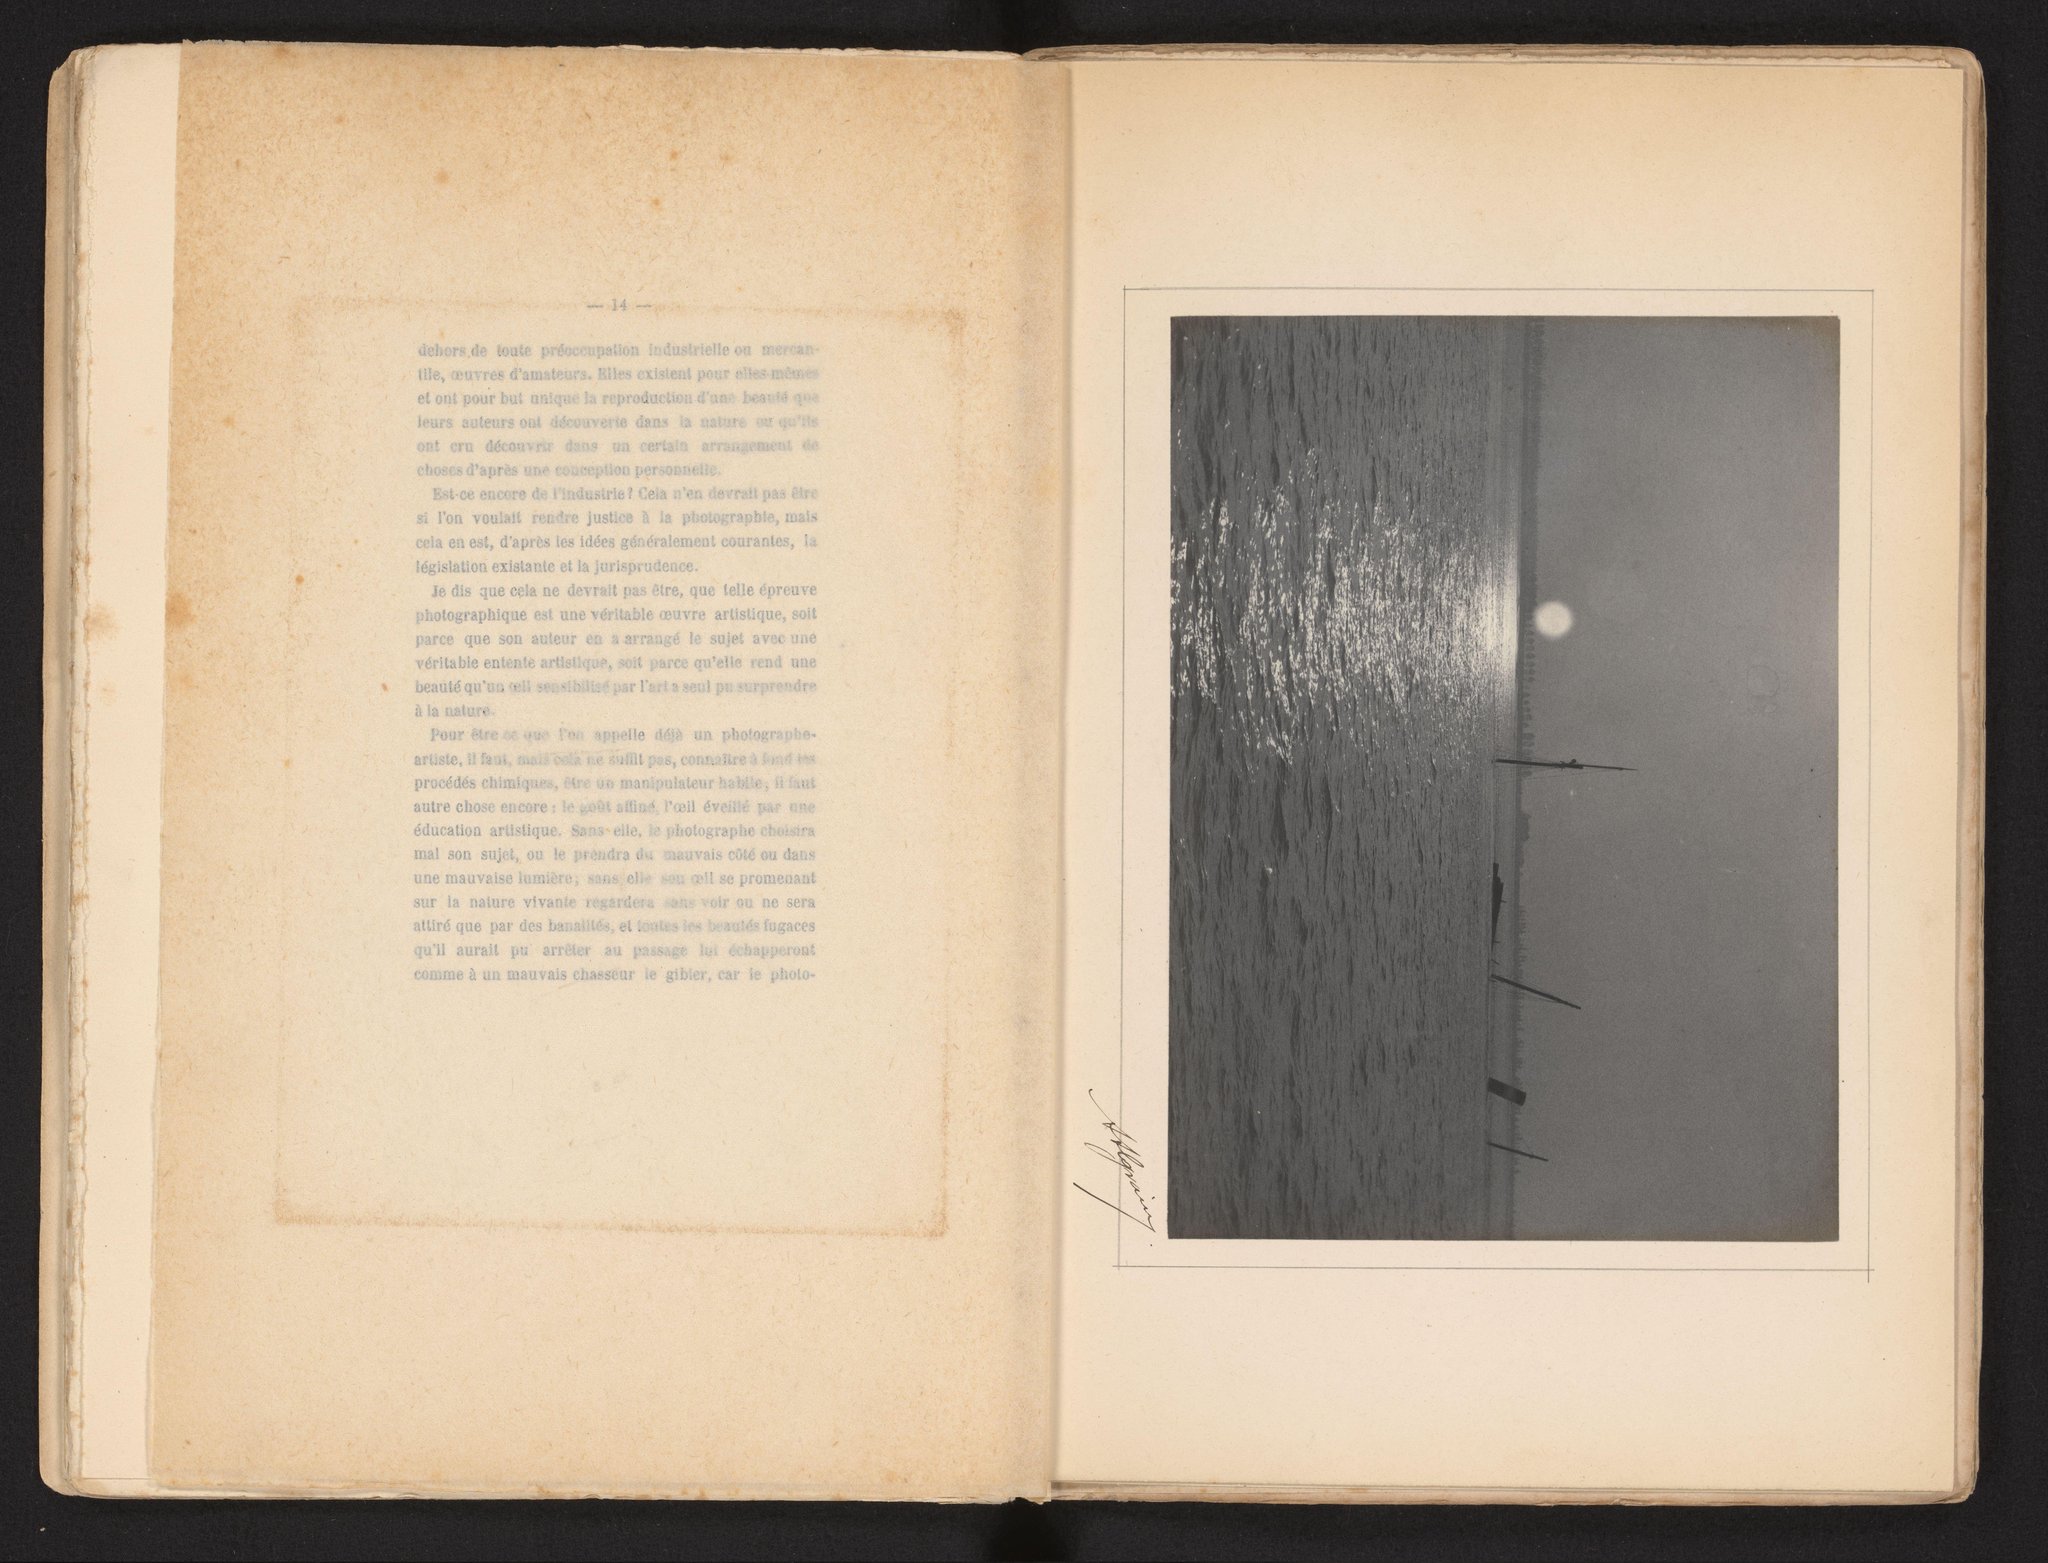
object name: photograph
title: Gezicht op een zinkend schip bij een ondergaande of opkomende zon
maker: alfred algrain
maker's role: fotograaf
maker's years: -1917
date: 1885-1890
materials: paper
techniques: platinum process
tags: landscapes with waters, waterscapes, seascapes (in the temperate zone), ships (in general), sun as celestial body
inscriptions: signature: ‘Algrain’